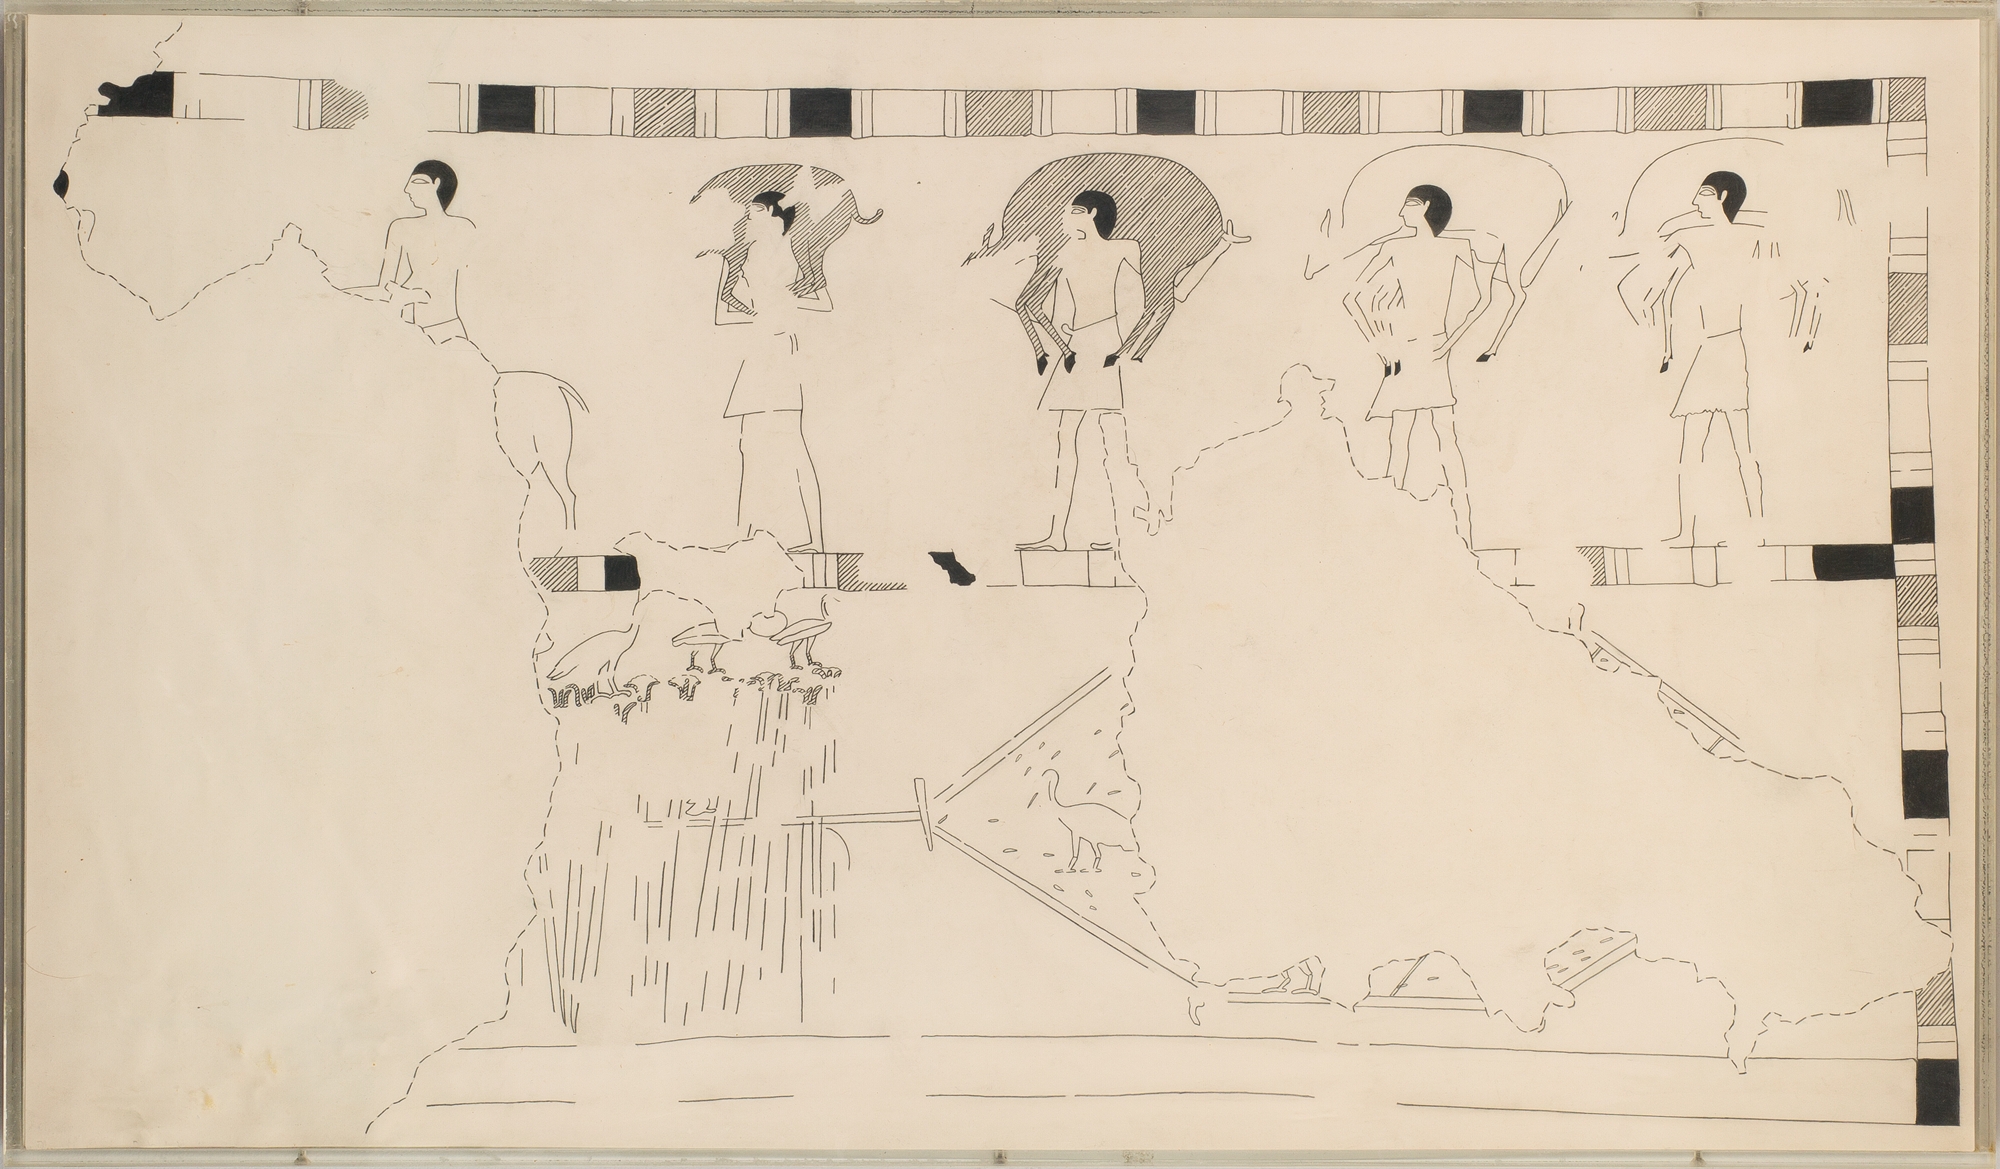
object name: facsimile, djari tt 366, offering, netting fowl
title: Offering Procession and Netting Fowl, Tomb of Djari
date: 2050-2000 BCE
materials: ink, paper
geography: egypt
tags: animals,men